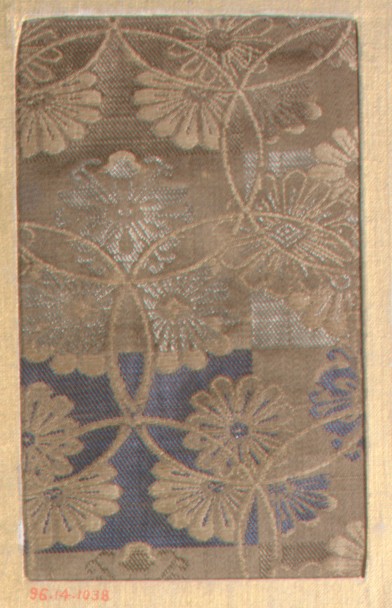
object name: piece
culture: japanese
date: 1701-1900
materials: silk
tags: flowers